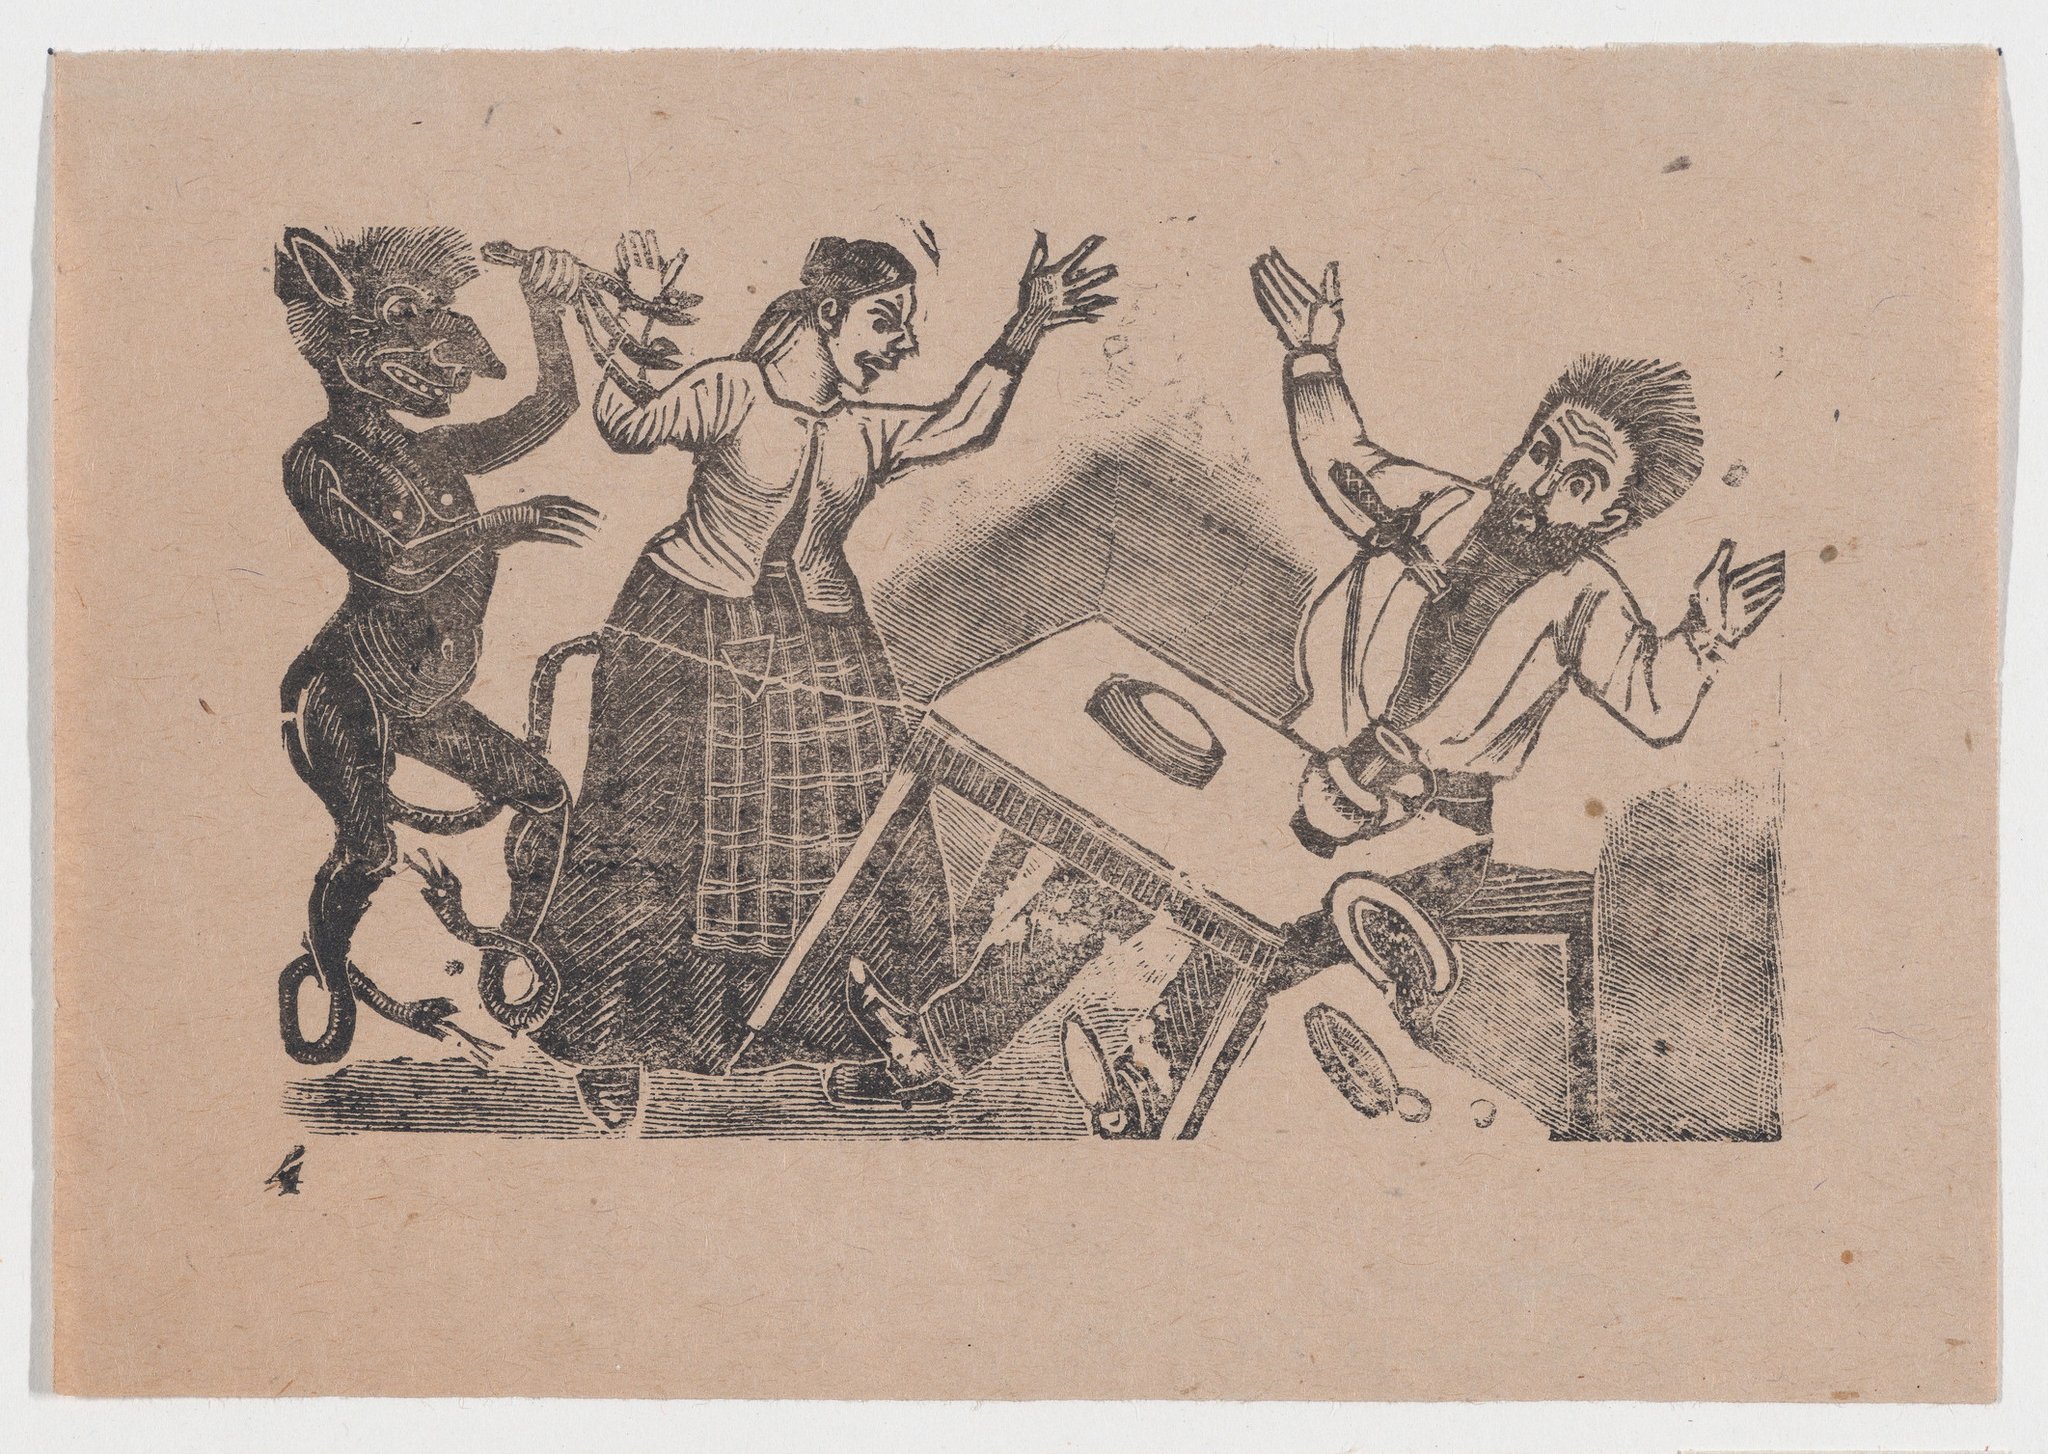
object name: print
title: Plate 4: The murder of a man by a knife thrown by a woman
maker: josé guadalupe posada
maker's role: artist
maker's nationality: mexican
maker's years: 1852-1913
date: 1892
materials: metal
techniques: engraving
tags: knives,men,women